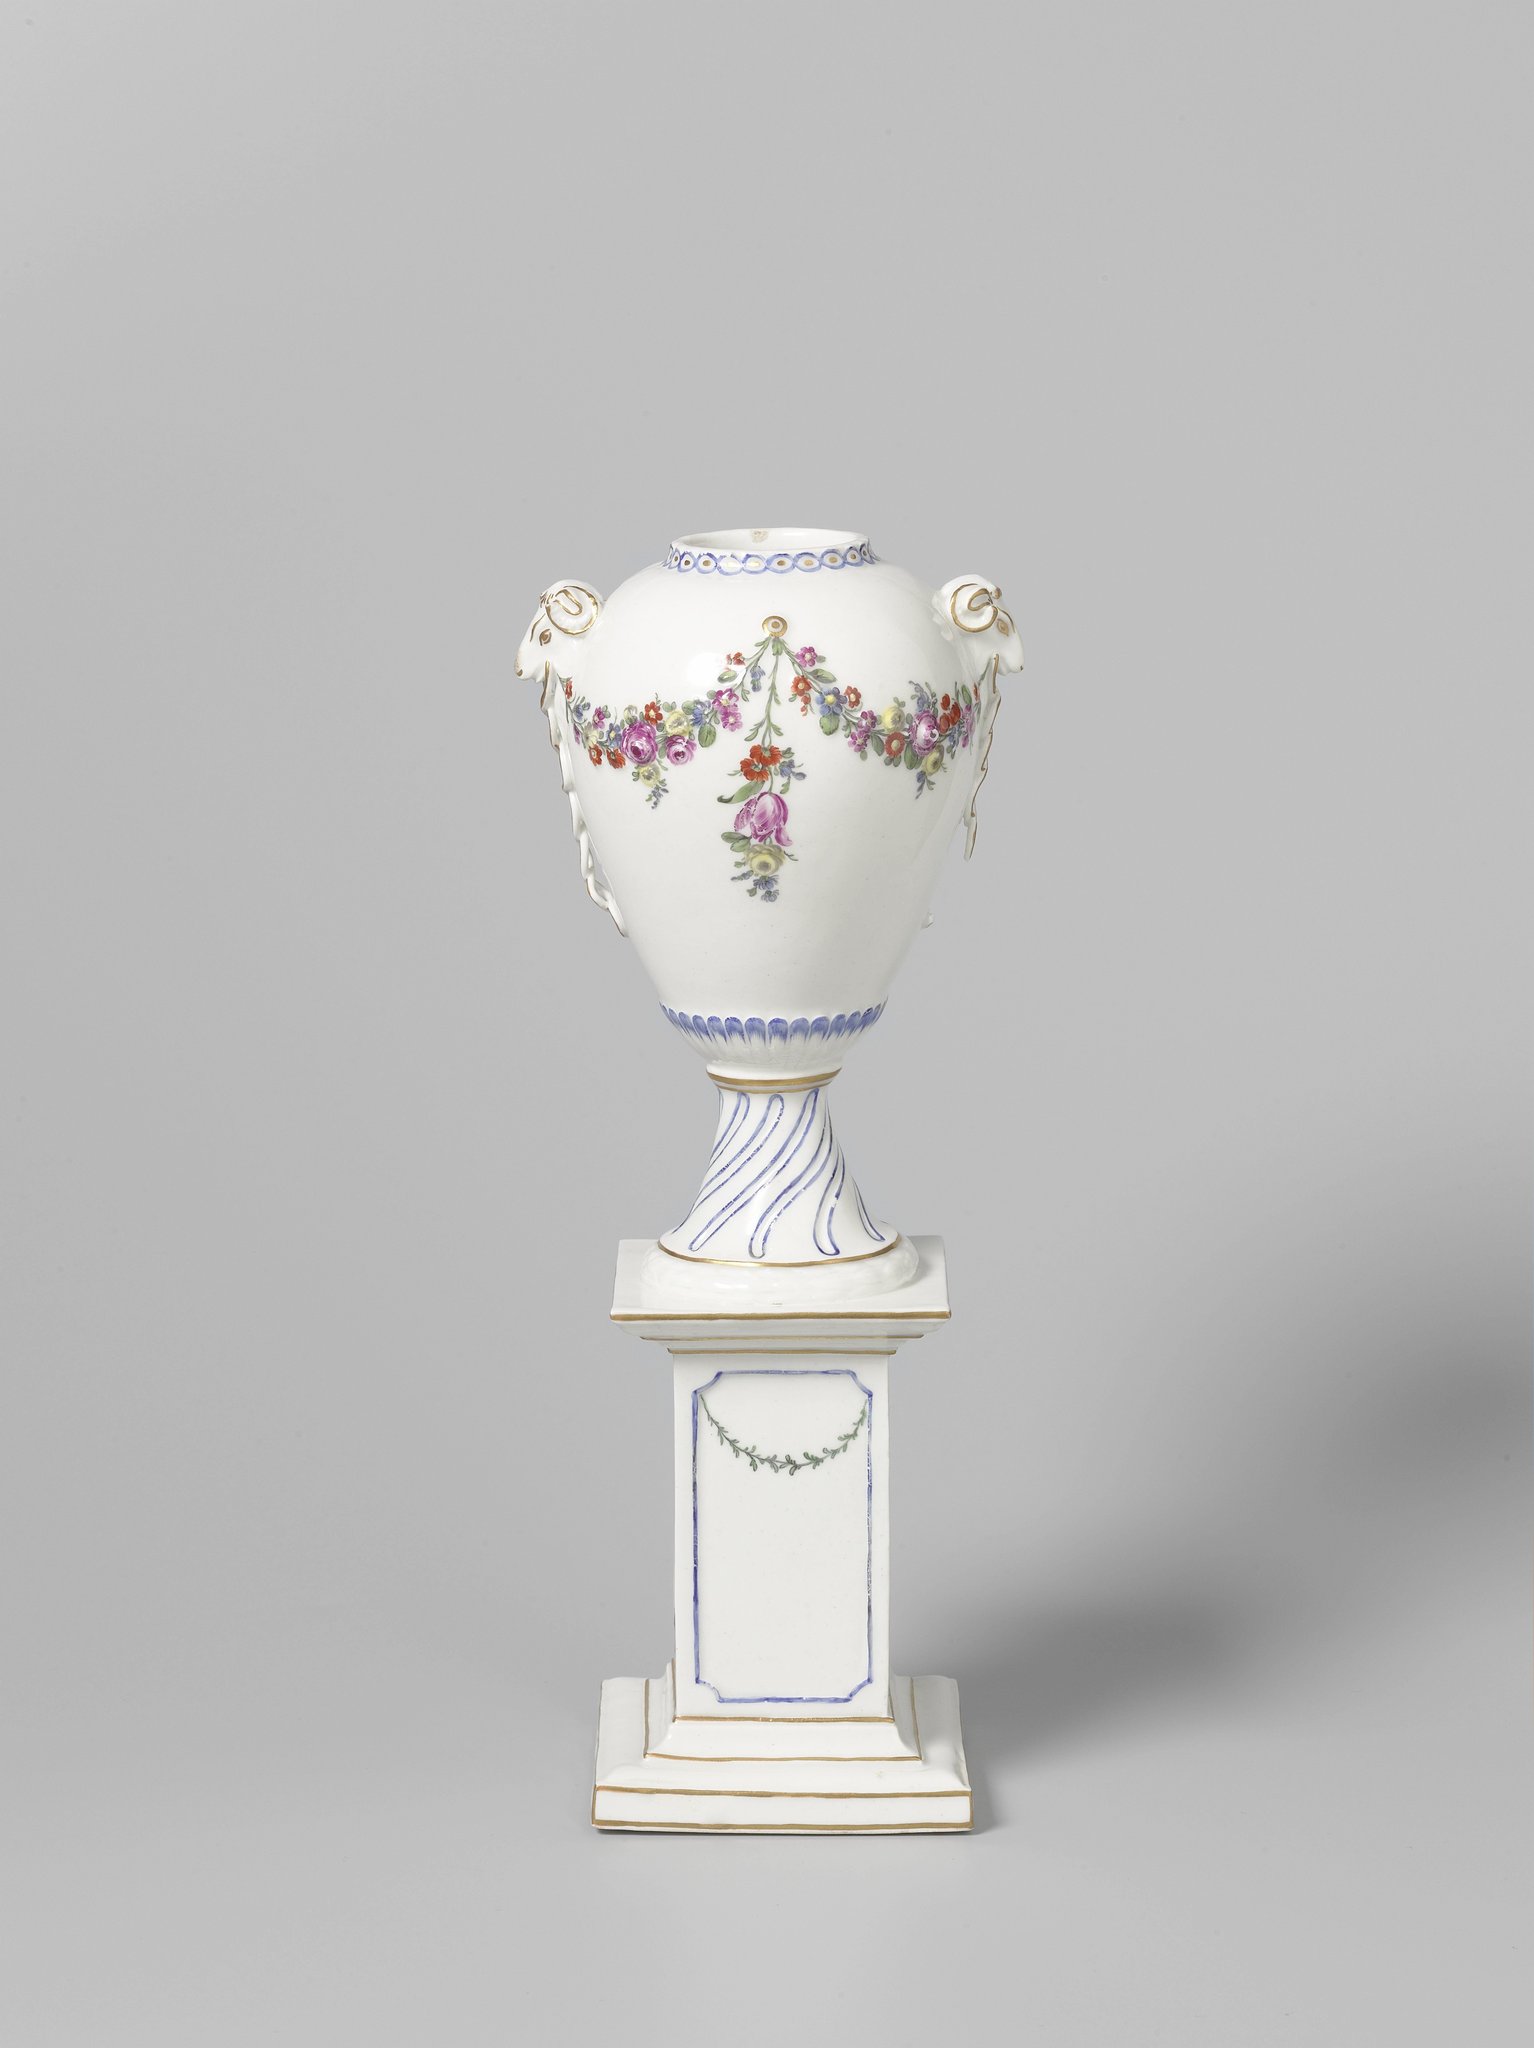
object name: vase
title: Kandelaar-vaas, beschilderd met bloemguirlandes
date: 1778-1782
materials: porcelain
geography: loosdrecht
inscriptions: mark: ‘L M 14’, mark: ‘MOL’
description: Vase/candlestick. Porcelain. Loosdrecht, c. 1778 - 1782. Factory of Joannes de Mol.